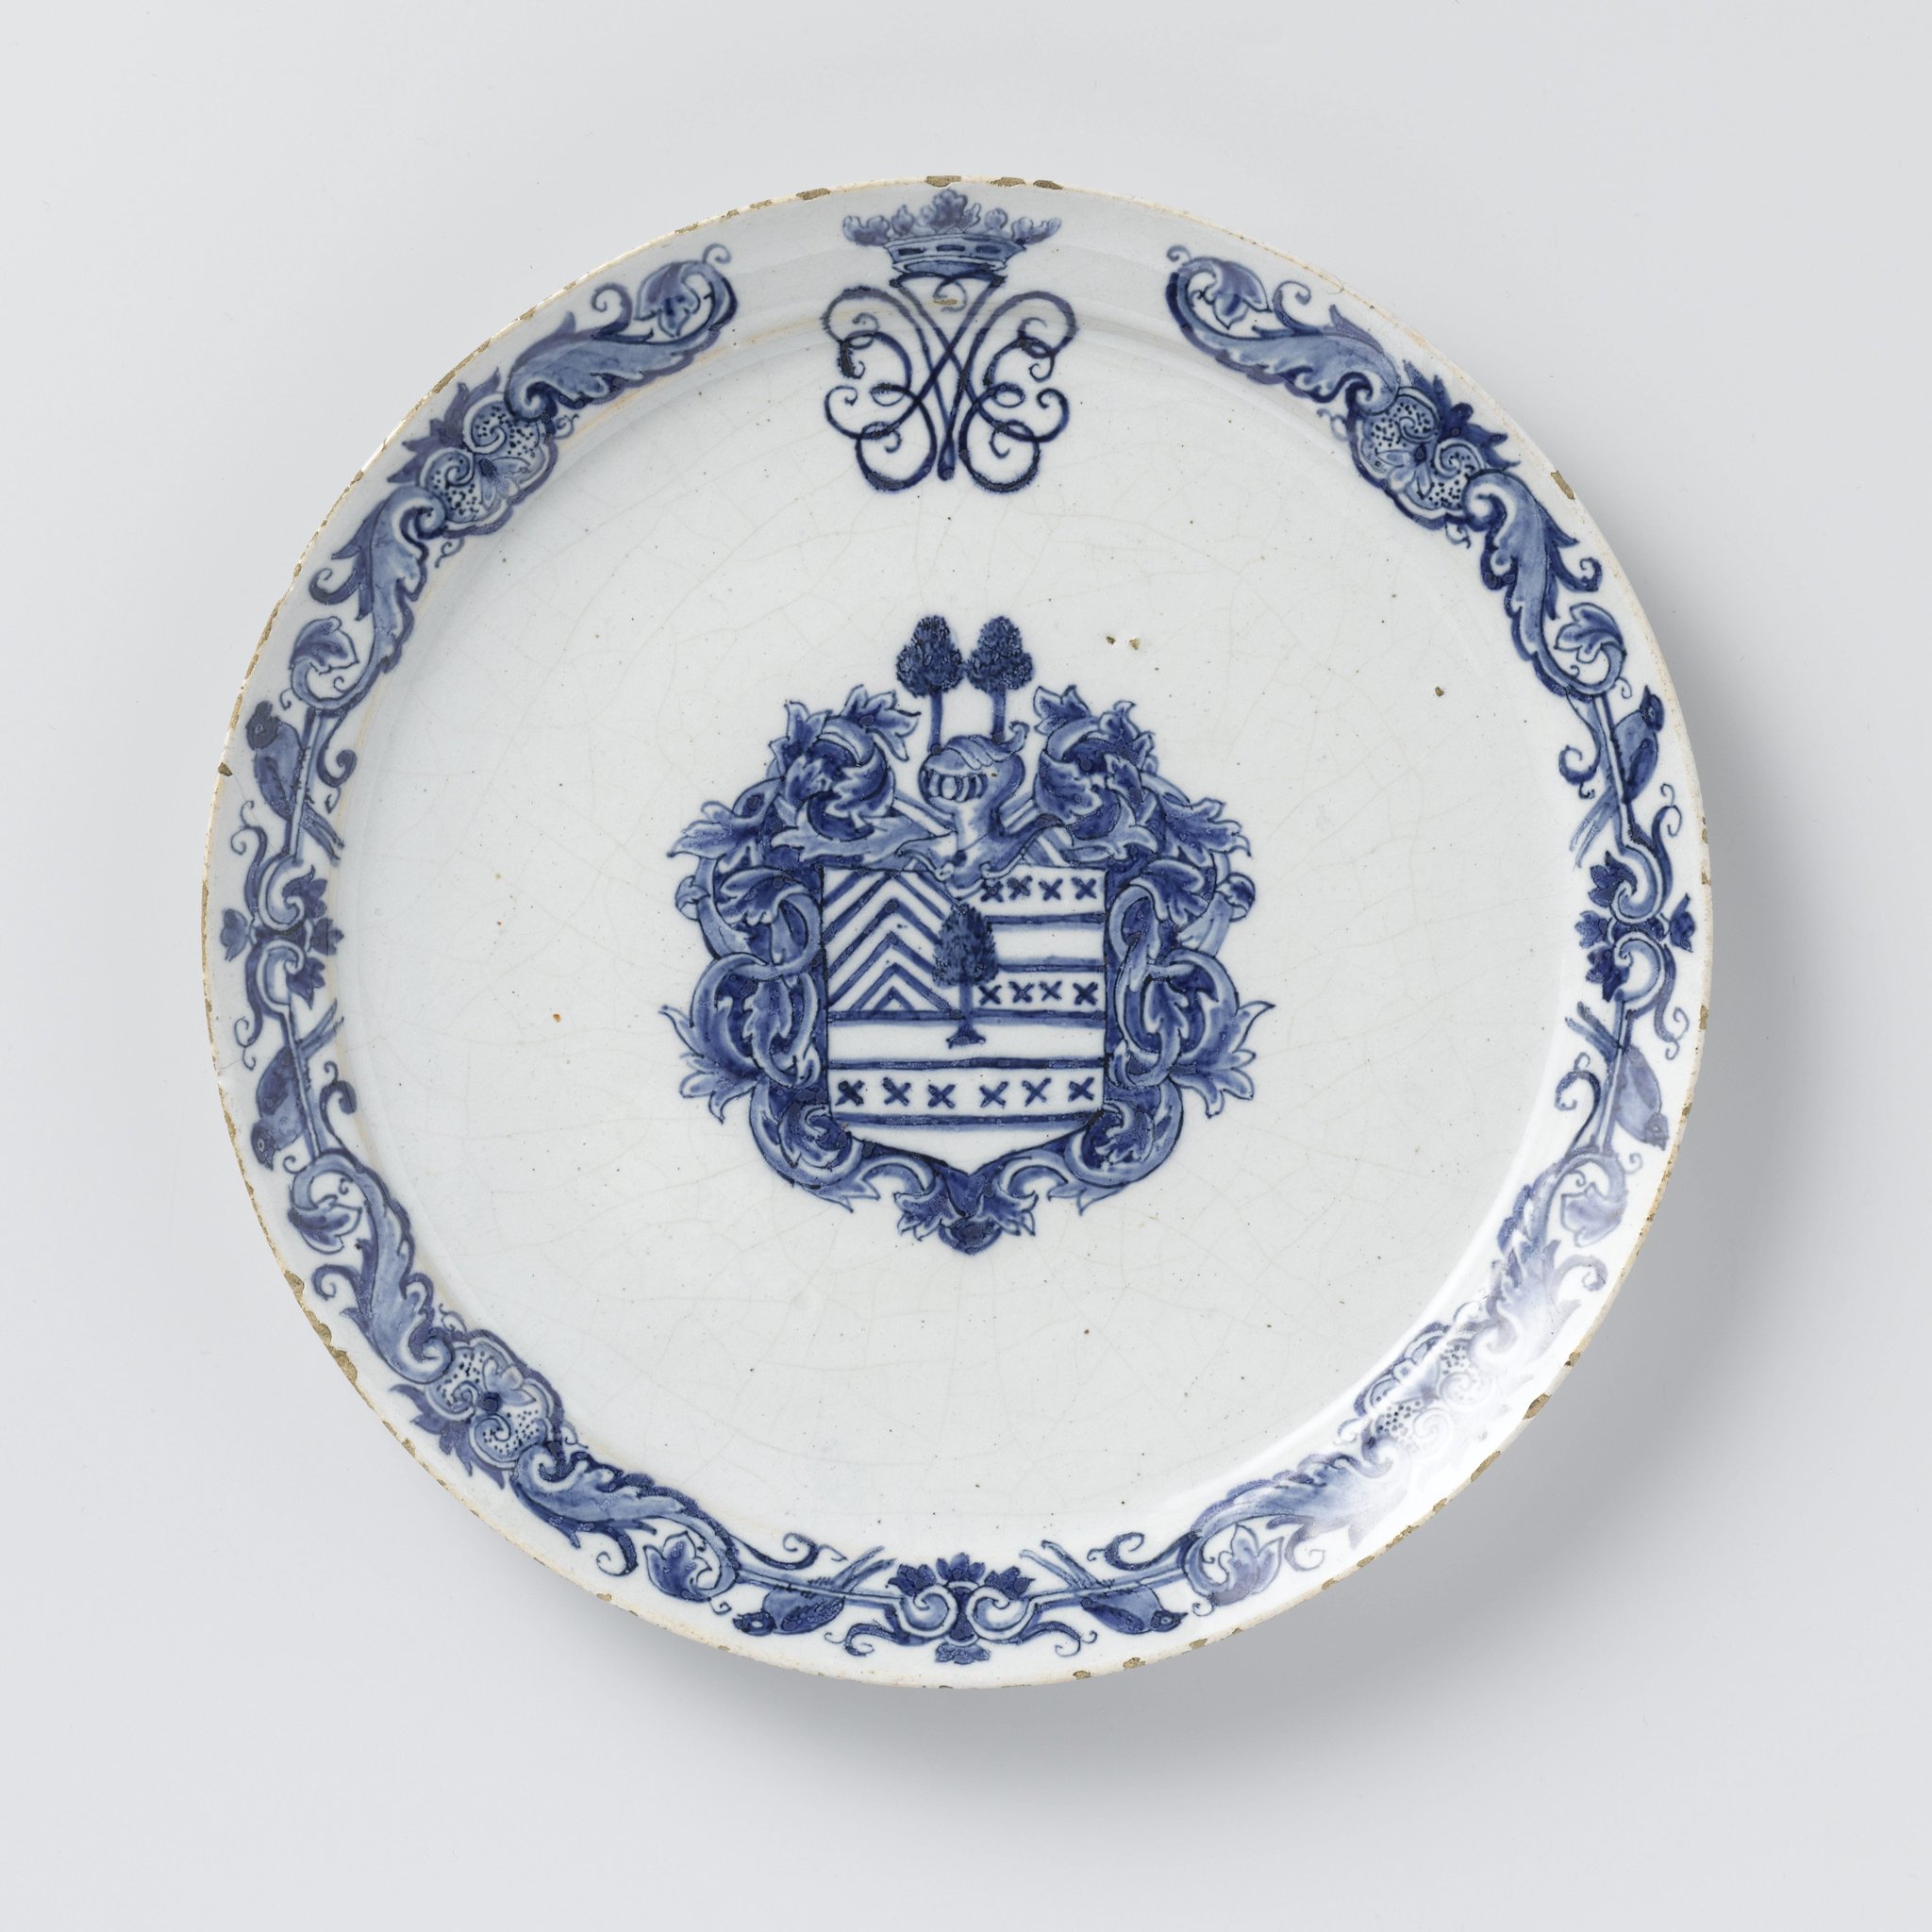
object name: plate dish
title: Bord, beschilderd met een onbekend wapen, mogelijk Van Egmond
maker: Anonymous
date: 1718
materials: faience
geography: delft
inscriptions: date: ‘1718’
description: Bord van aardewerk beschilderd in blauw op tinglazuur met in het plat een onbekend wapen, mogelijk van een lid van een onbekend geslacht Van Egmond. Daarboven een gekroond spiegelmonogram J.V.E. De rand gedecoreerd met bladwerk.